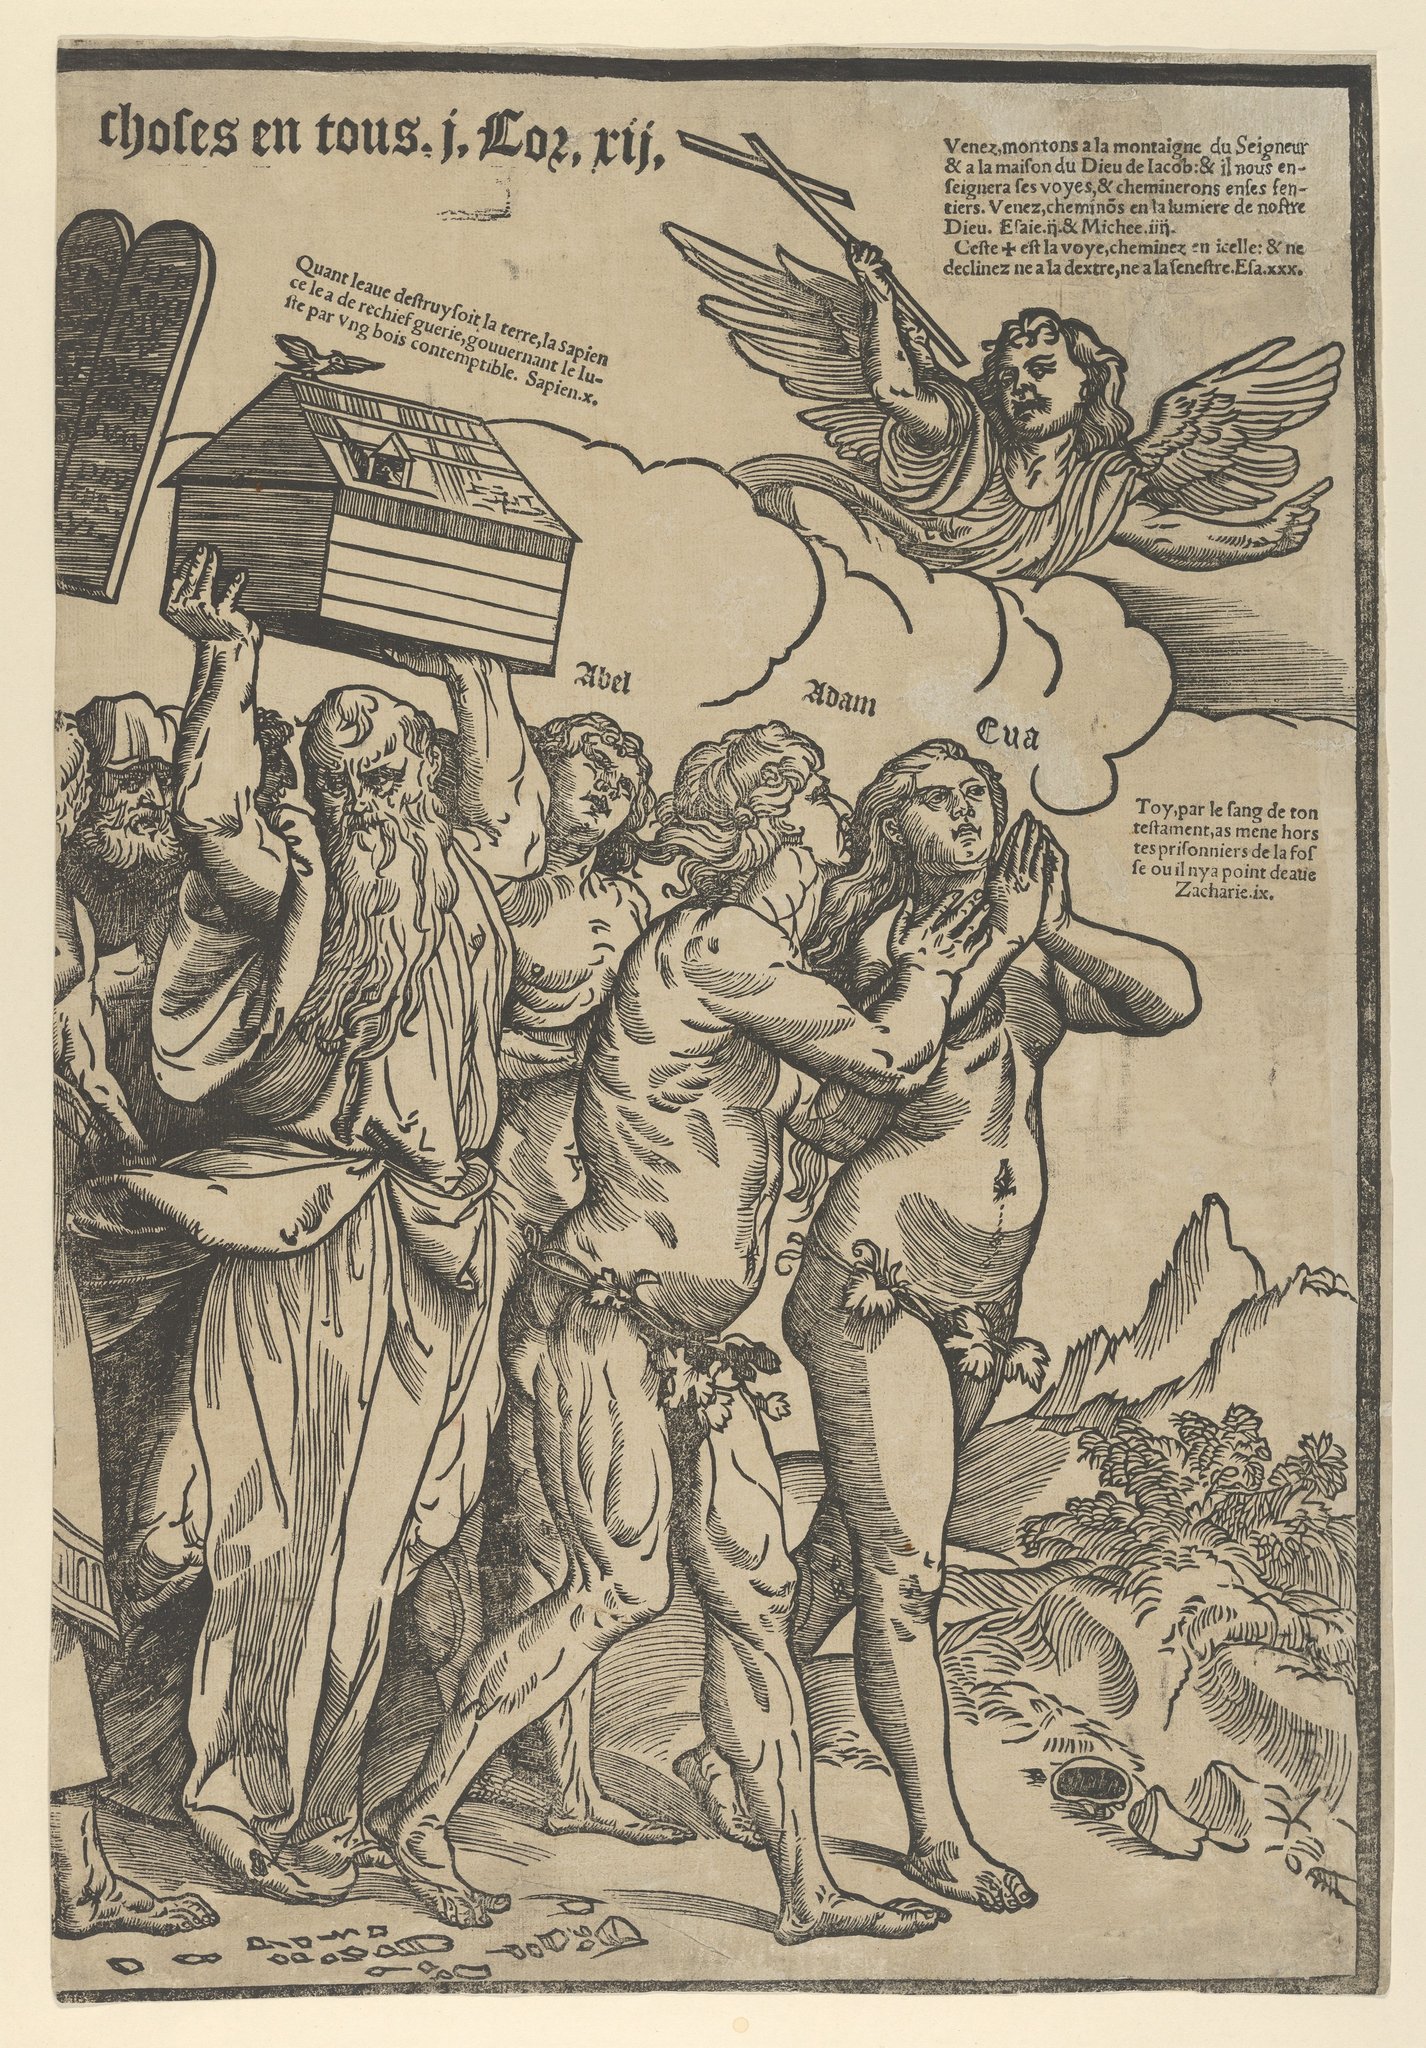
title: The Triumph of Christ: the last sheet on the right showing Adam and Eve who lead the procession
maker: Anonymous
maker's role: artist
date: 1510-1511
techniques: woodcut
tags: houses,angels,christ,adam,eve